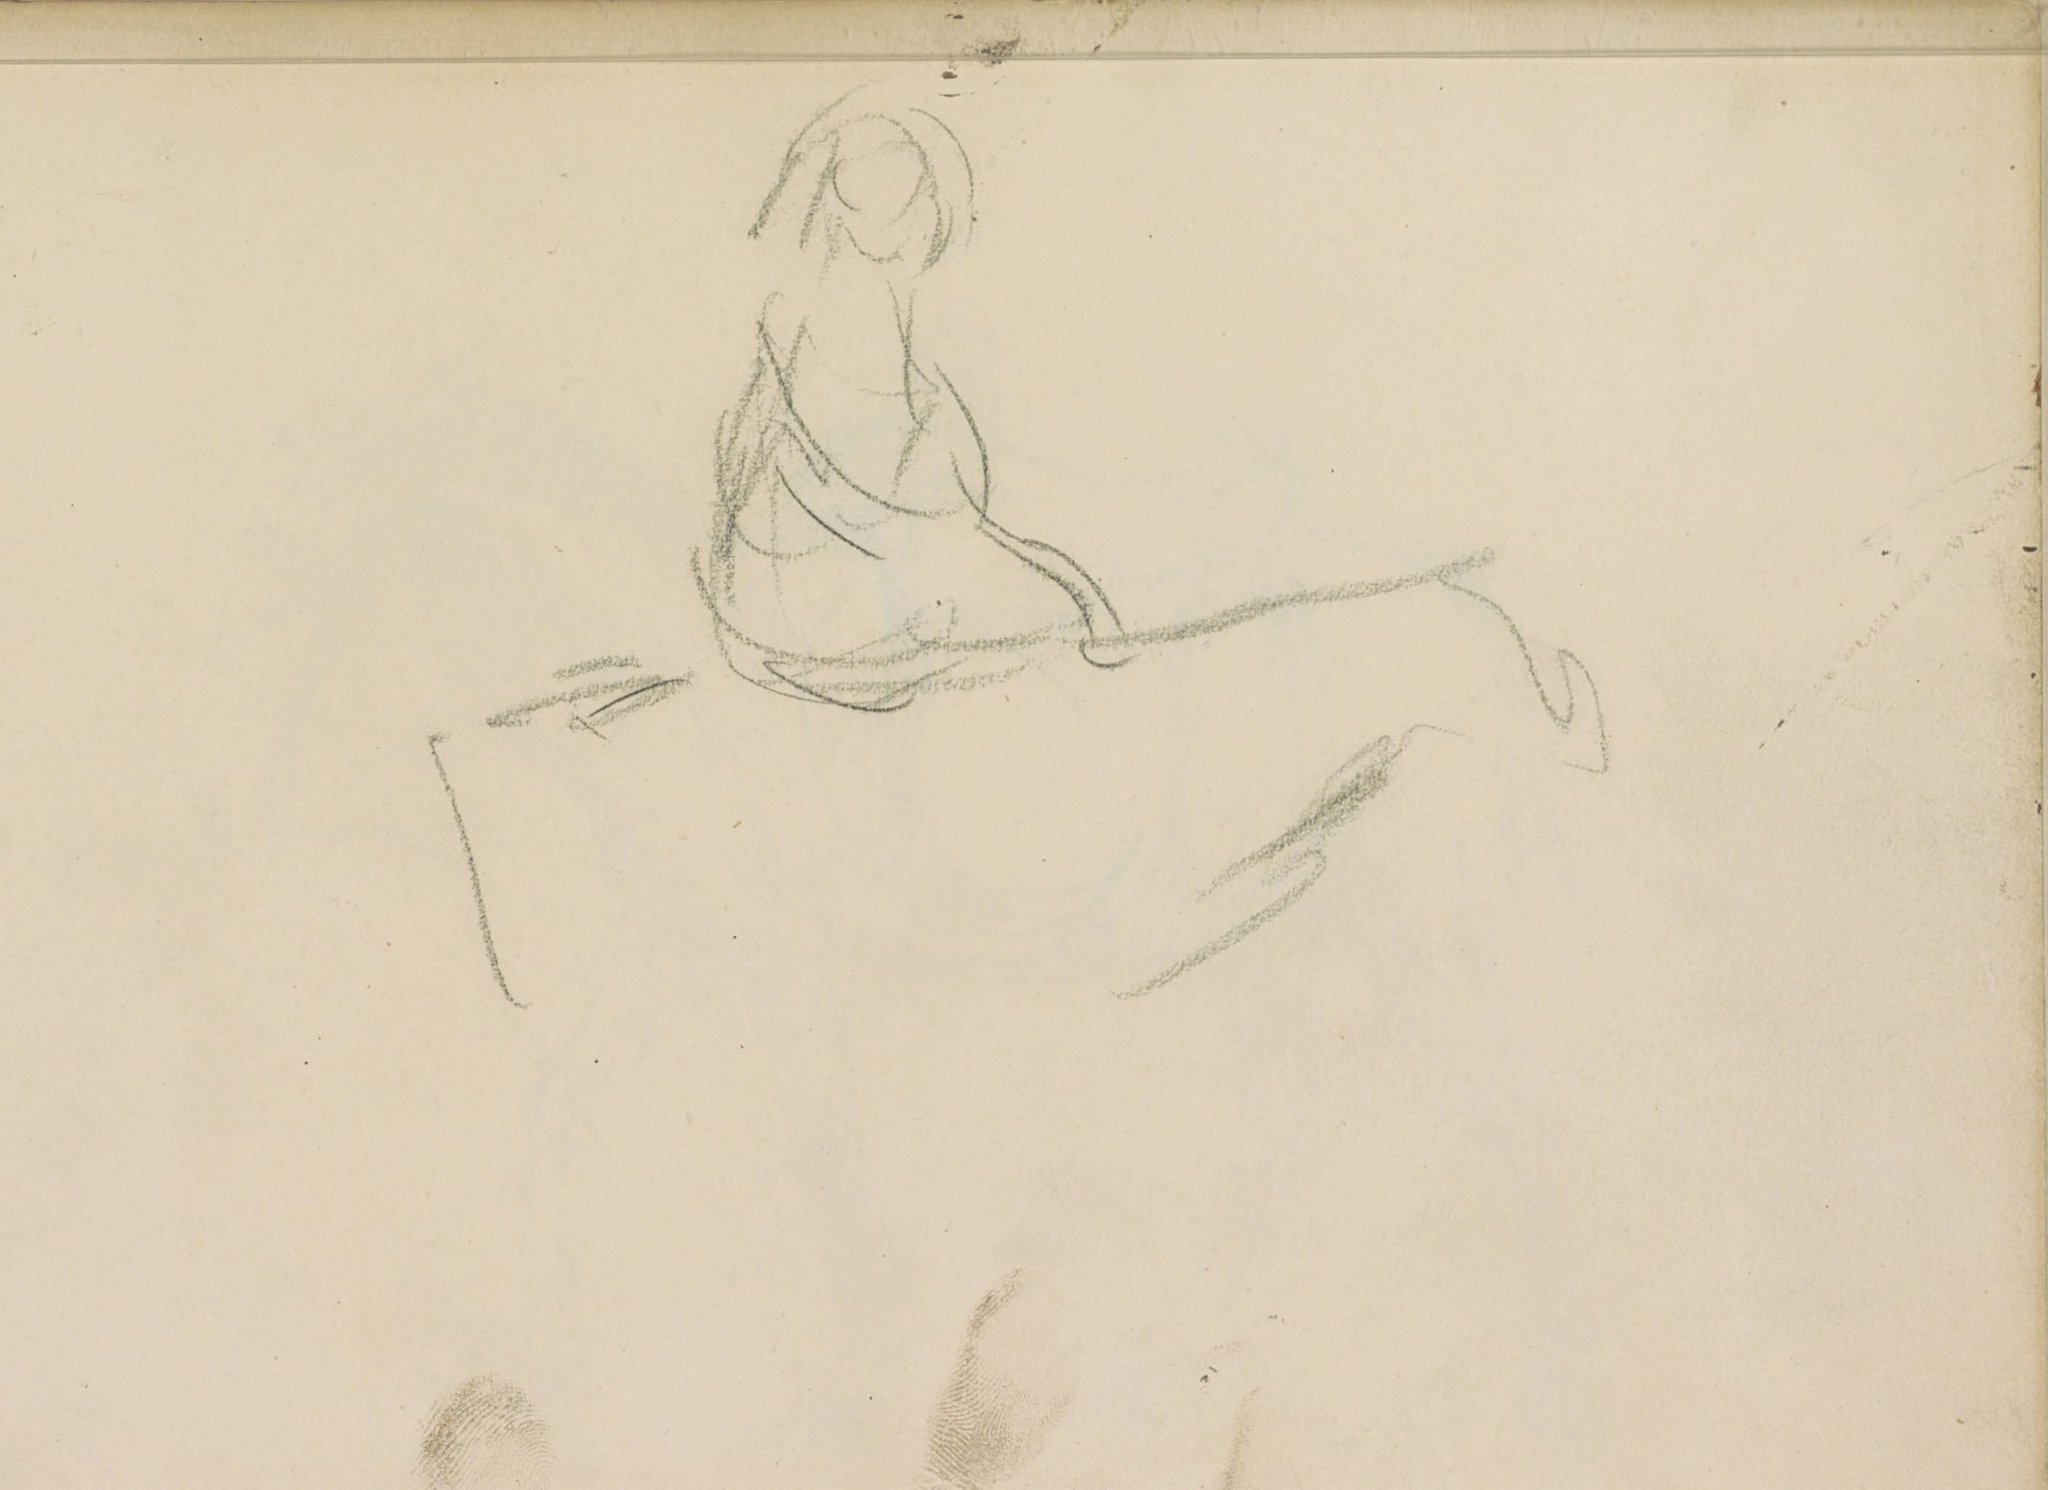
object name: sketchbook leaf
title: Figuur op een hoefdier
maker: isaac israels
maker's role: draughtsman, painter, print maker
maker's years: 1865-1934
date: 1890-1920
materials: chalk, paper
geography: the hague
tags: riding a horse, ass, or mule; rider, horseman, girl (child between toddler and youth)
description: Mogelijk een meisje op een ezel. Blad 1 recto uit schetsboek X met 43 bladen.